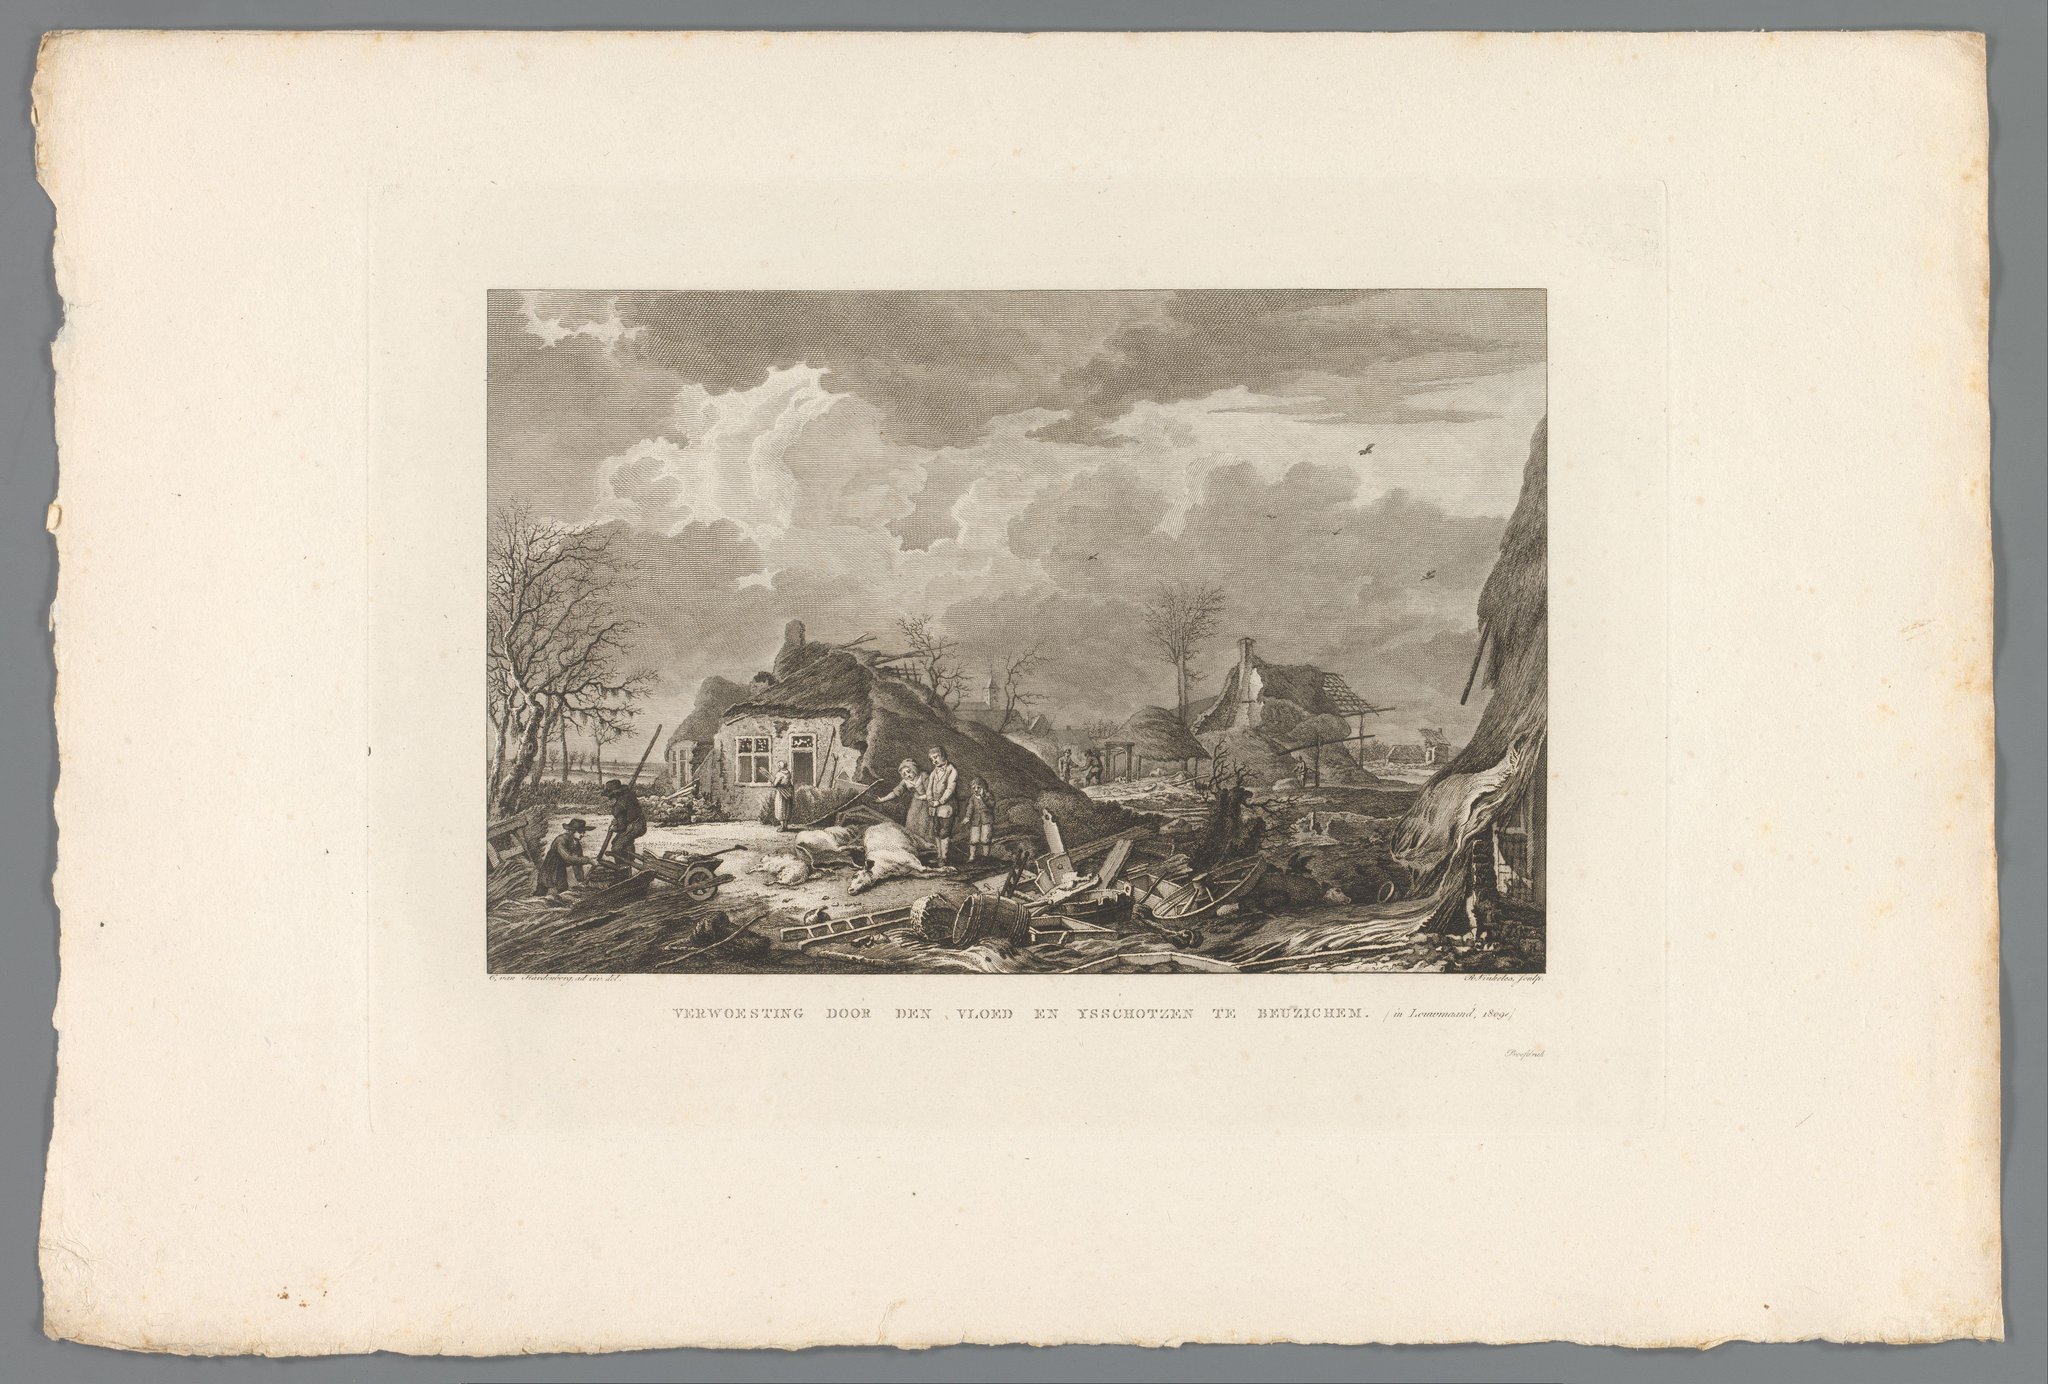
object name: print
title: Prenten en kaarten horend bij het geschiedkundig verslag van de overstromingen in Zuid-Holland en Gelderland in januari 1809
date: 1809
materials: paper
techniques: engraving, etching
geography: amsterdam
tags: flood, death by drowning (non-violent), ruin of a dwelling, house, castle, etc.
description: Prent ook gebruikt ter illustratie van: Hendrik Ewijk. Geschiedkundig verslag der dijkbreuken en overstroomingen, langs de rivieren in het Koningrijk Holland, voorgevallen in louwmaand MDCCCIX. 3 dln. Amsterdam: Johannes Allart en Jacobus Ruys, 1809.